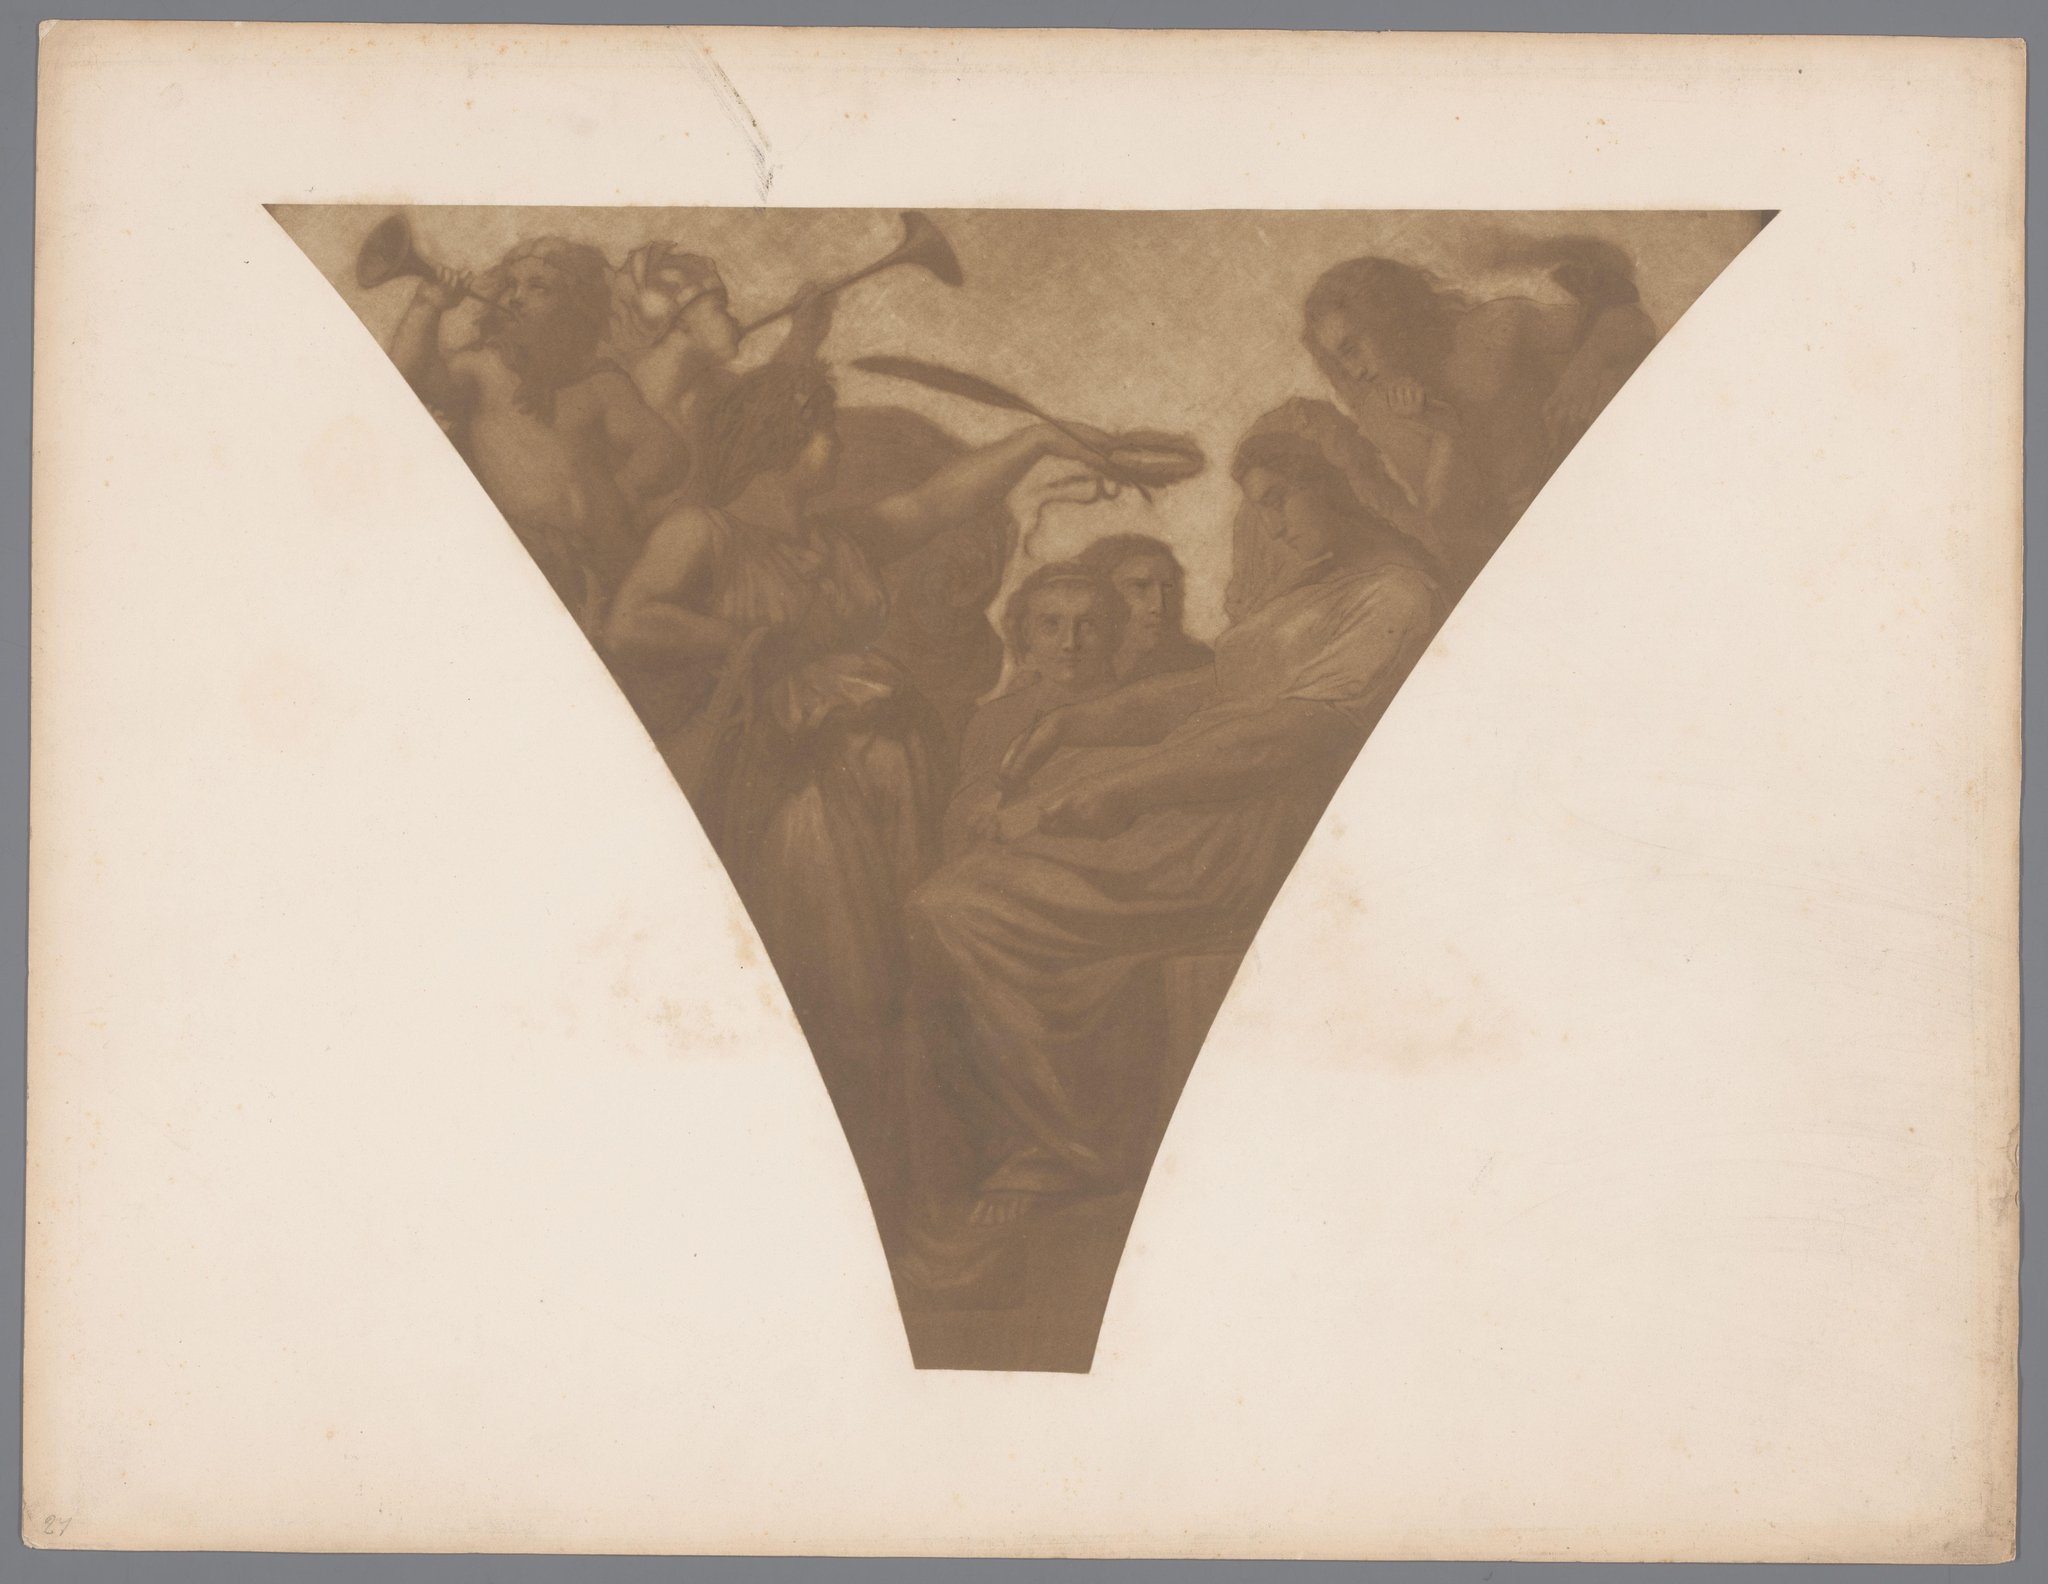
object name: photograph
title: Fotografische reproductie van decoratie aan plafond, Hotel de Ville, Parijs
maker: gustave le gray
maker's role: fotograaf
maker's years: 1820-1884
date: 1852-1853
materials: cardboard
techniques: salted paper print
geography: paris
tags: paris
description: Maakt onderdeel uit van een serie van 18 bladen met foto's van de cartons voor de plafondschilderingen door Henri Lehmann voor de Galerie des Fêtes in het Hotel de Ville, Parijs.